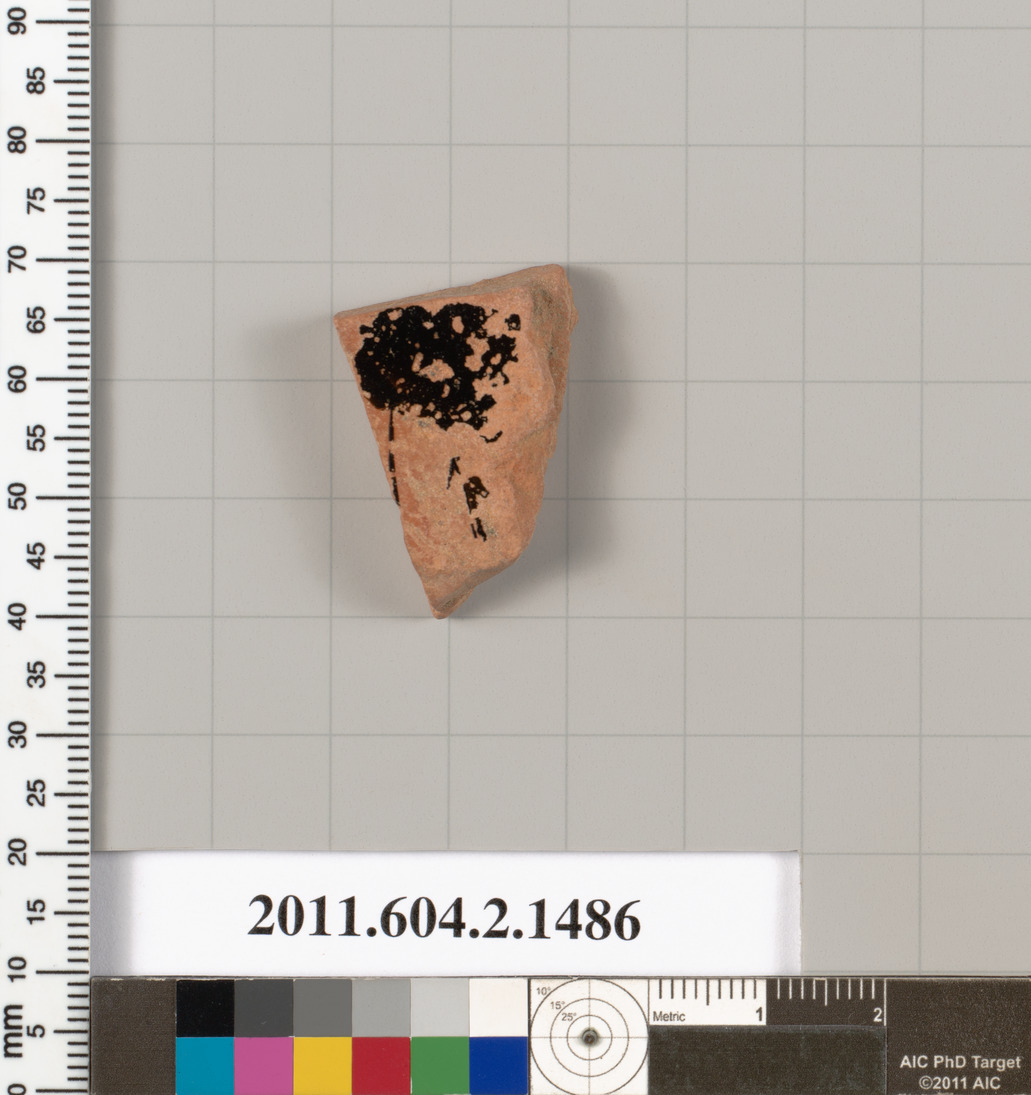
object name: skyphos fragment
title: Terracotta fragment of a skyphos (deep drinking cup)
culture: greek, attic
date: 475-451 BCE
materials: terracotta